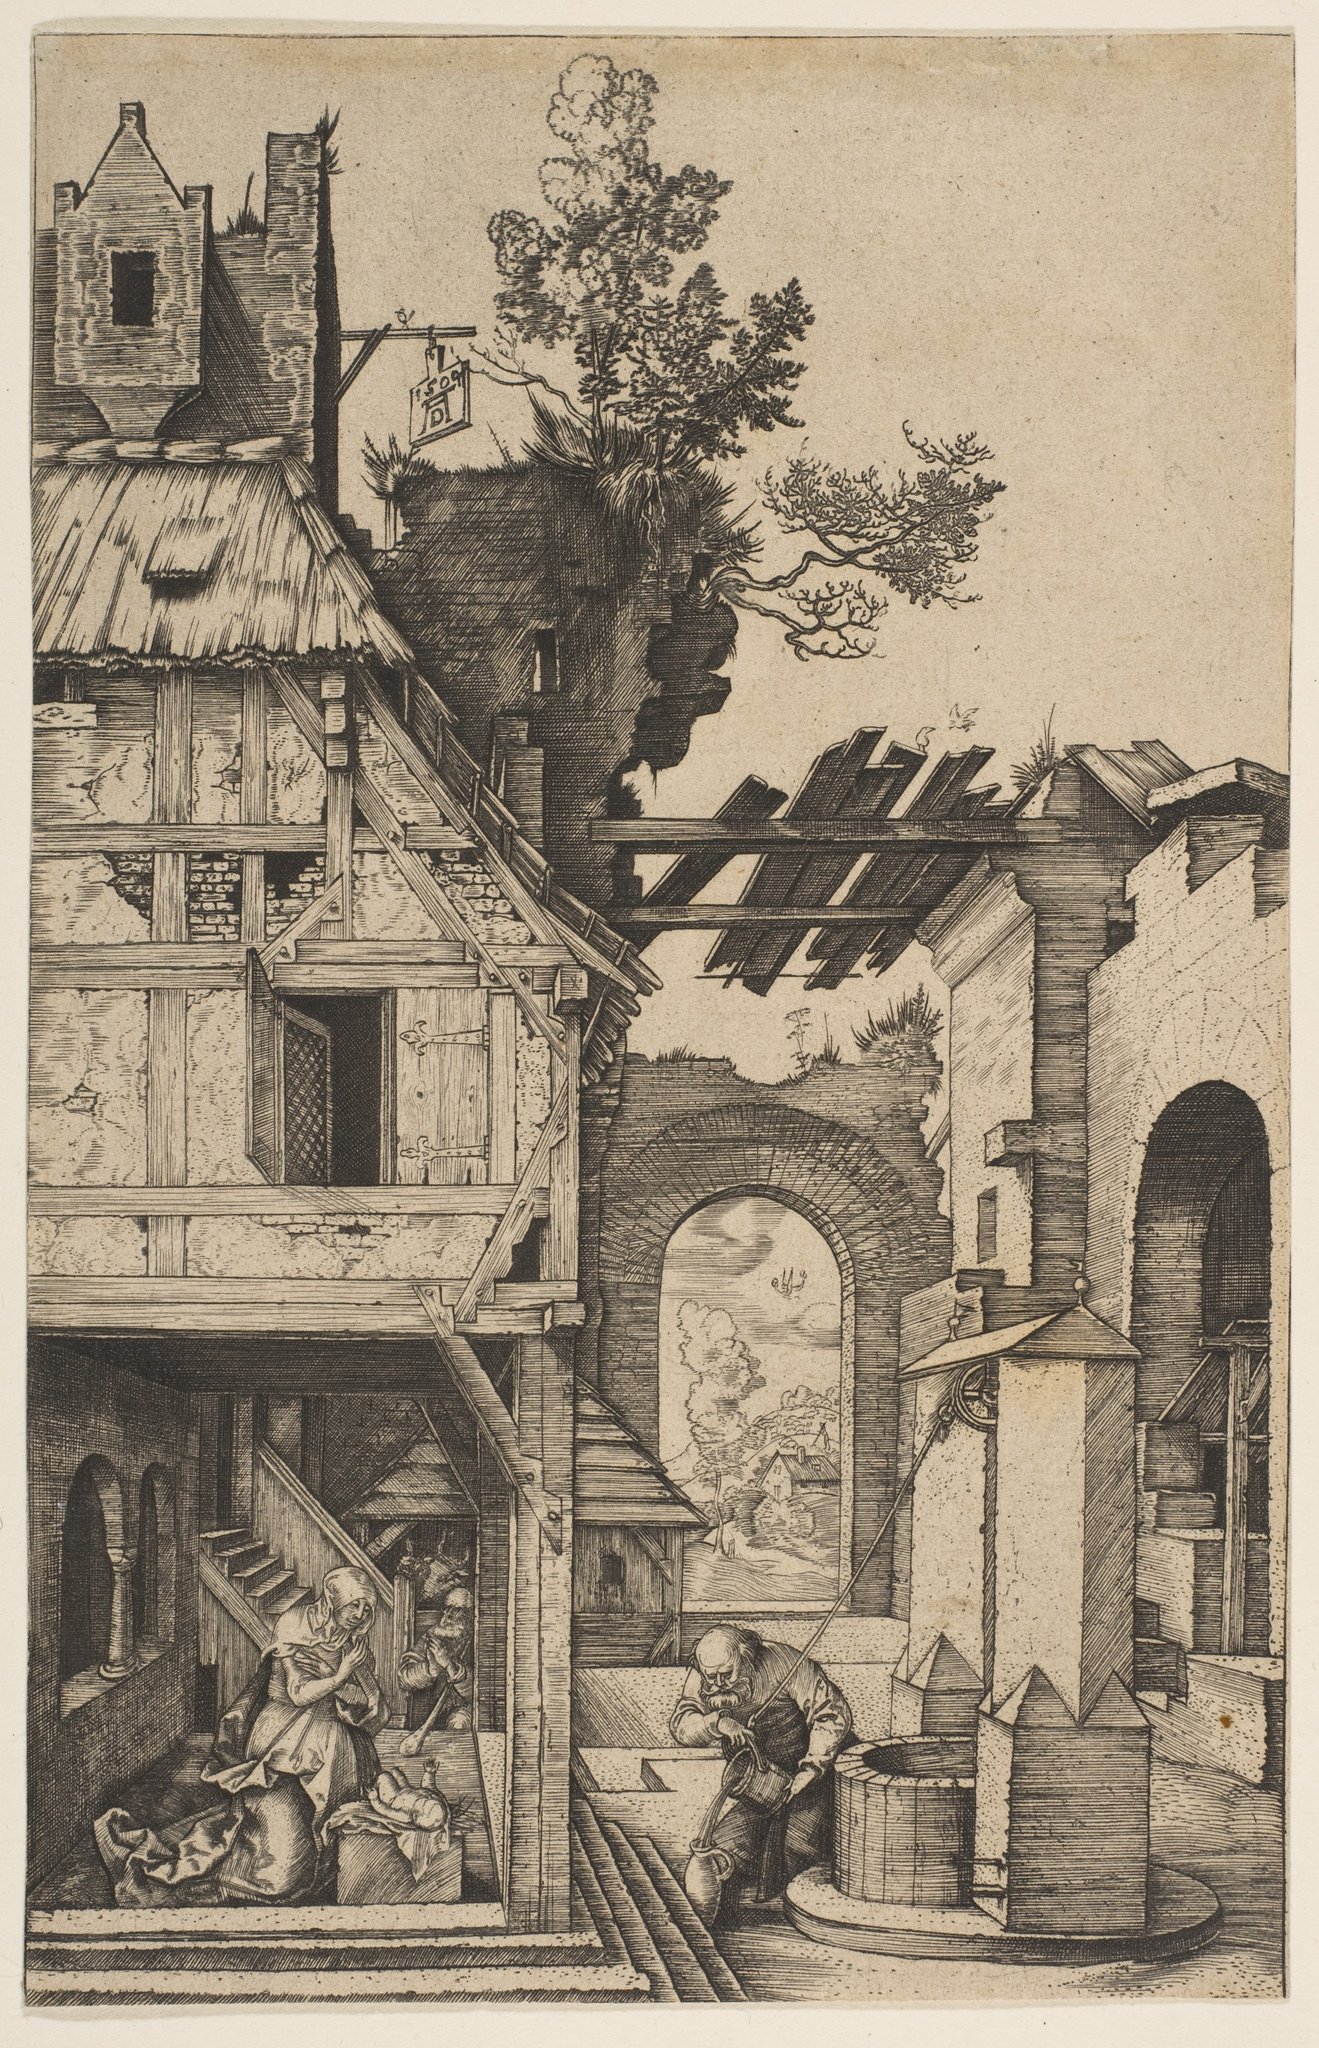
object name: print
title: The Nativity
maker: albrecht dürer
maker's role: artist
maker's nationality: german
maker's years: 1471-1528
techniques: engraving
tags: wells,men,women,virgin mary,jesus,nativity